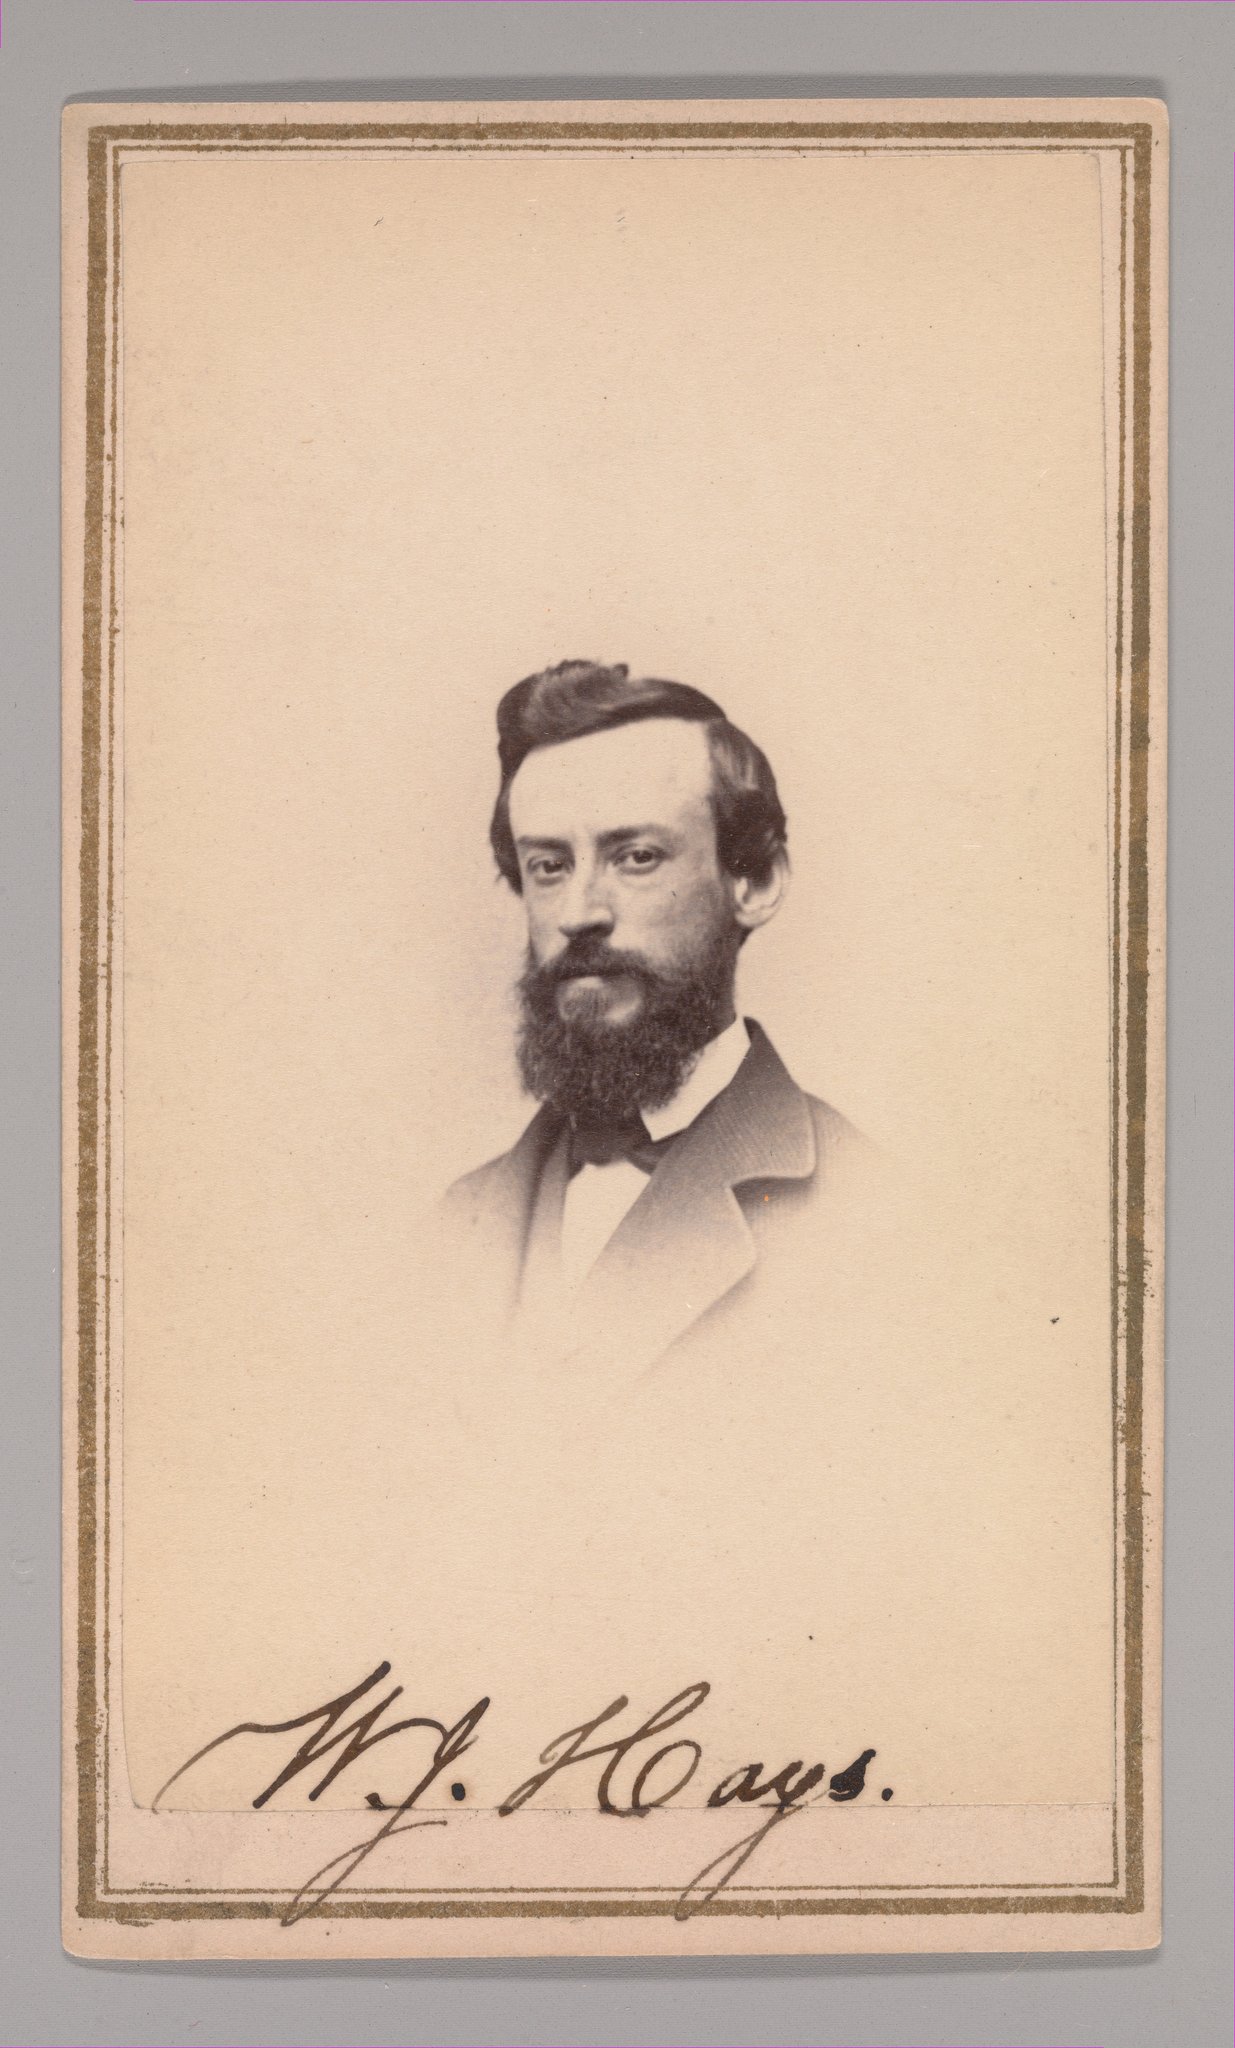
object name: carte de visite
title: [William Jacob Hays, Sr.]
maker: whitney & paradise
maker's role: photography studio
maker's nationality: american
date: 1860-1869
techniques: albumen silver print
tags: men,portraits